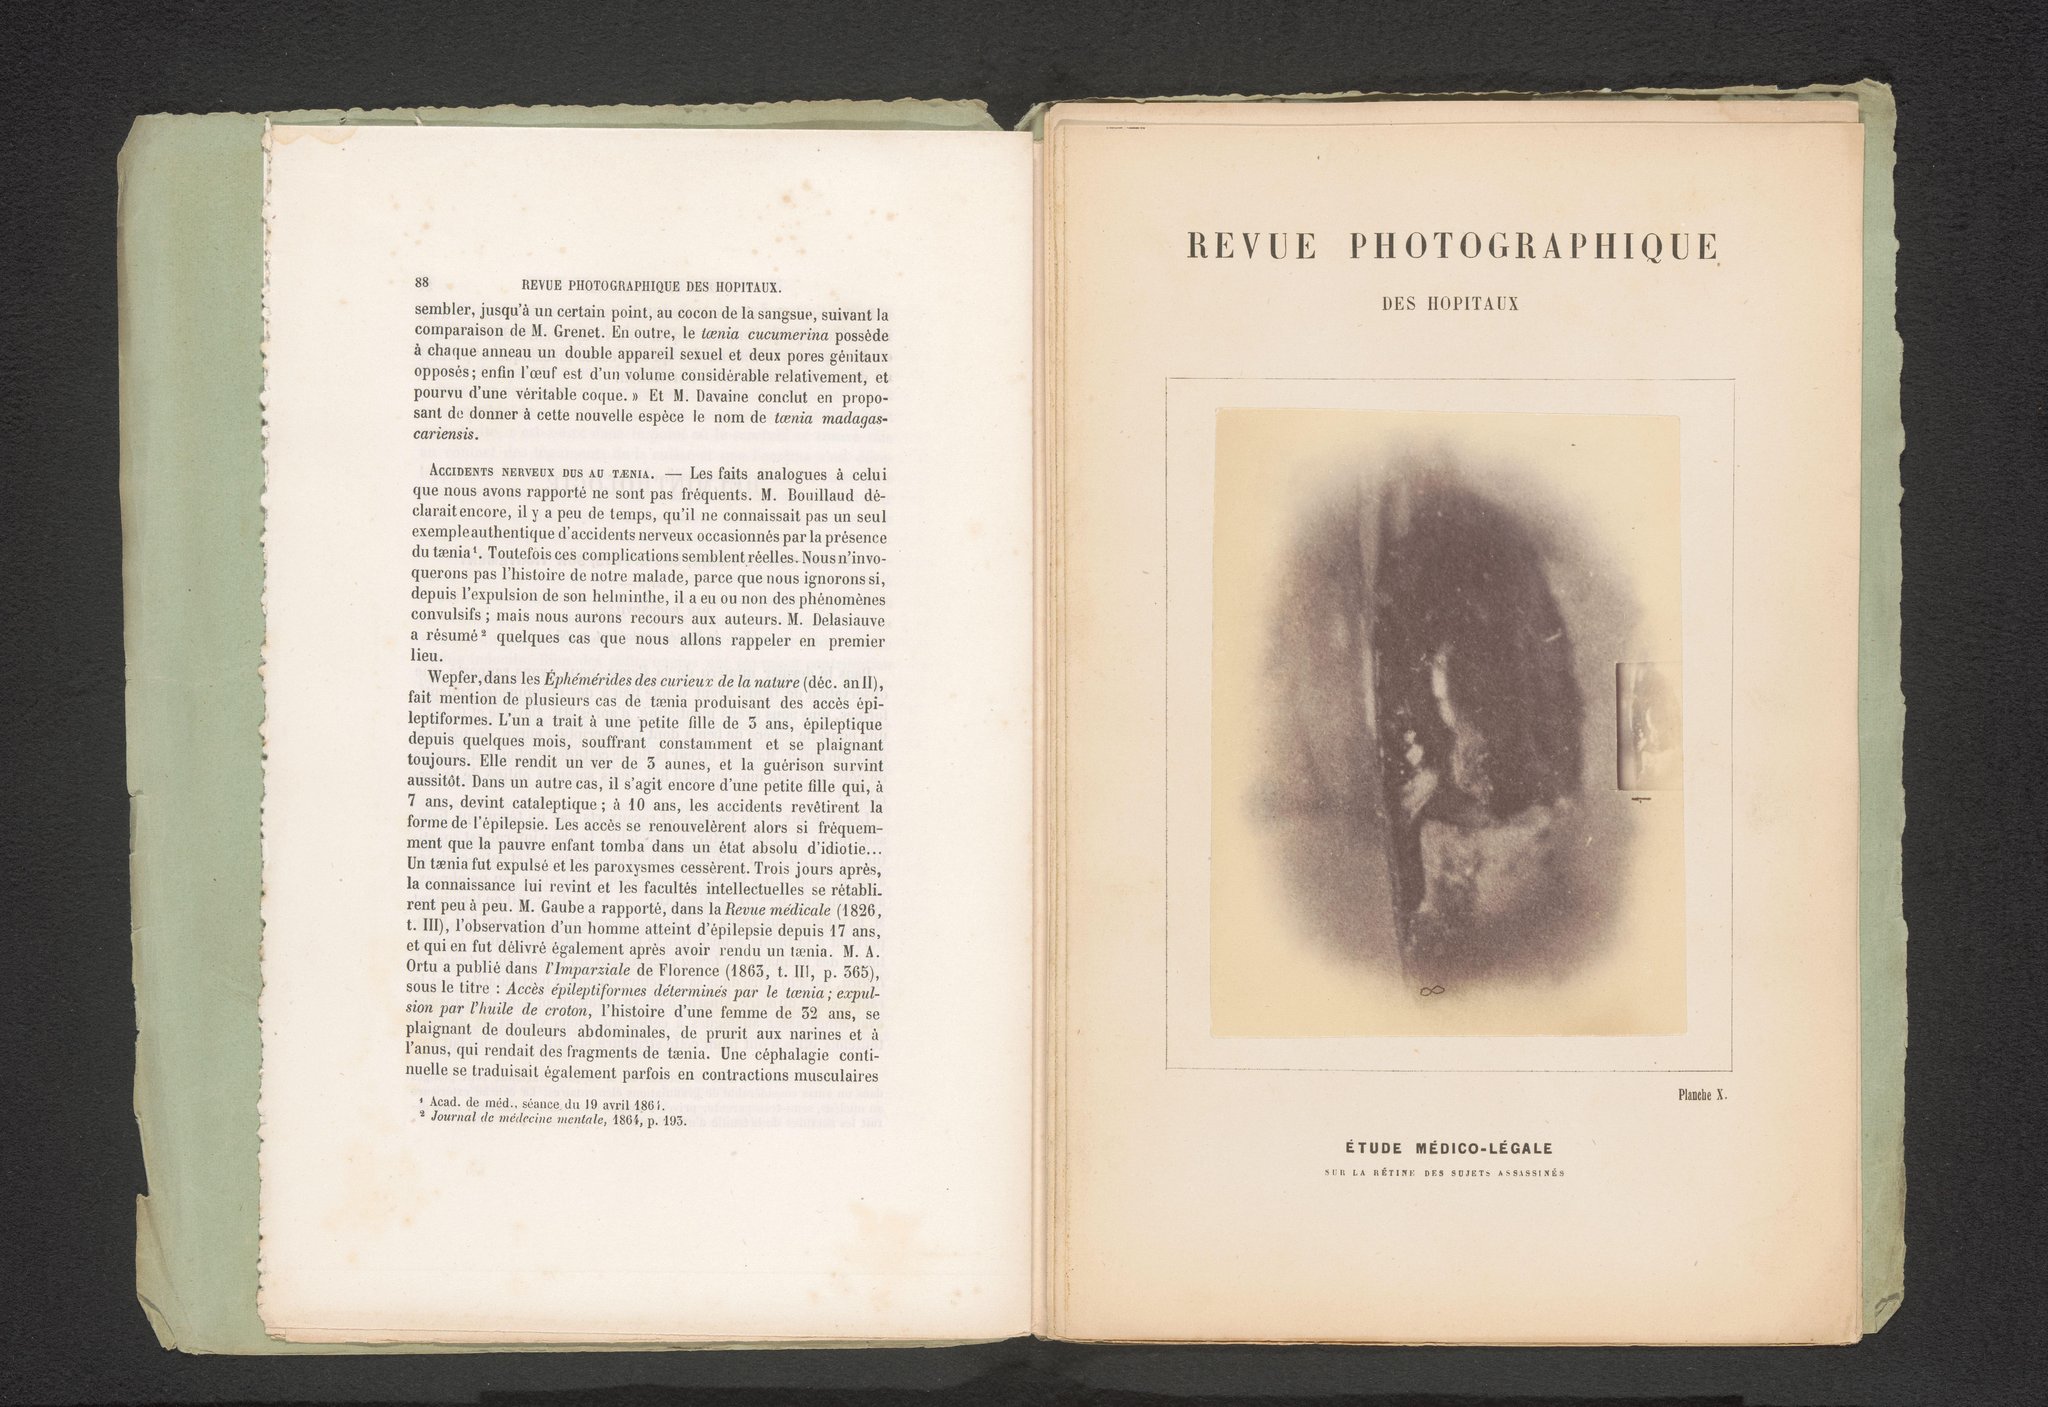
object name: page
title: Étude médico-légale sur la rétine des sujets assassinés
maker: Anonymous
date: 1865-1870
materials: paper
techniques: albumen print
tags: medicine, medical science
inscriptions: inscription: ‘Revue photographique/ des hopitaux/ Planche X.’